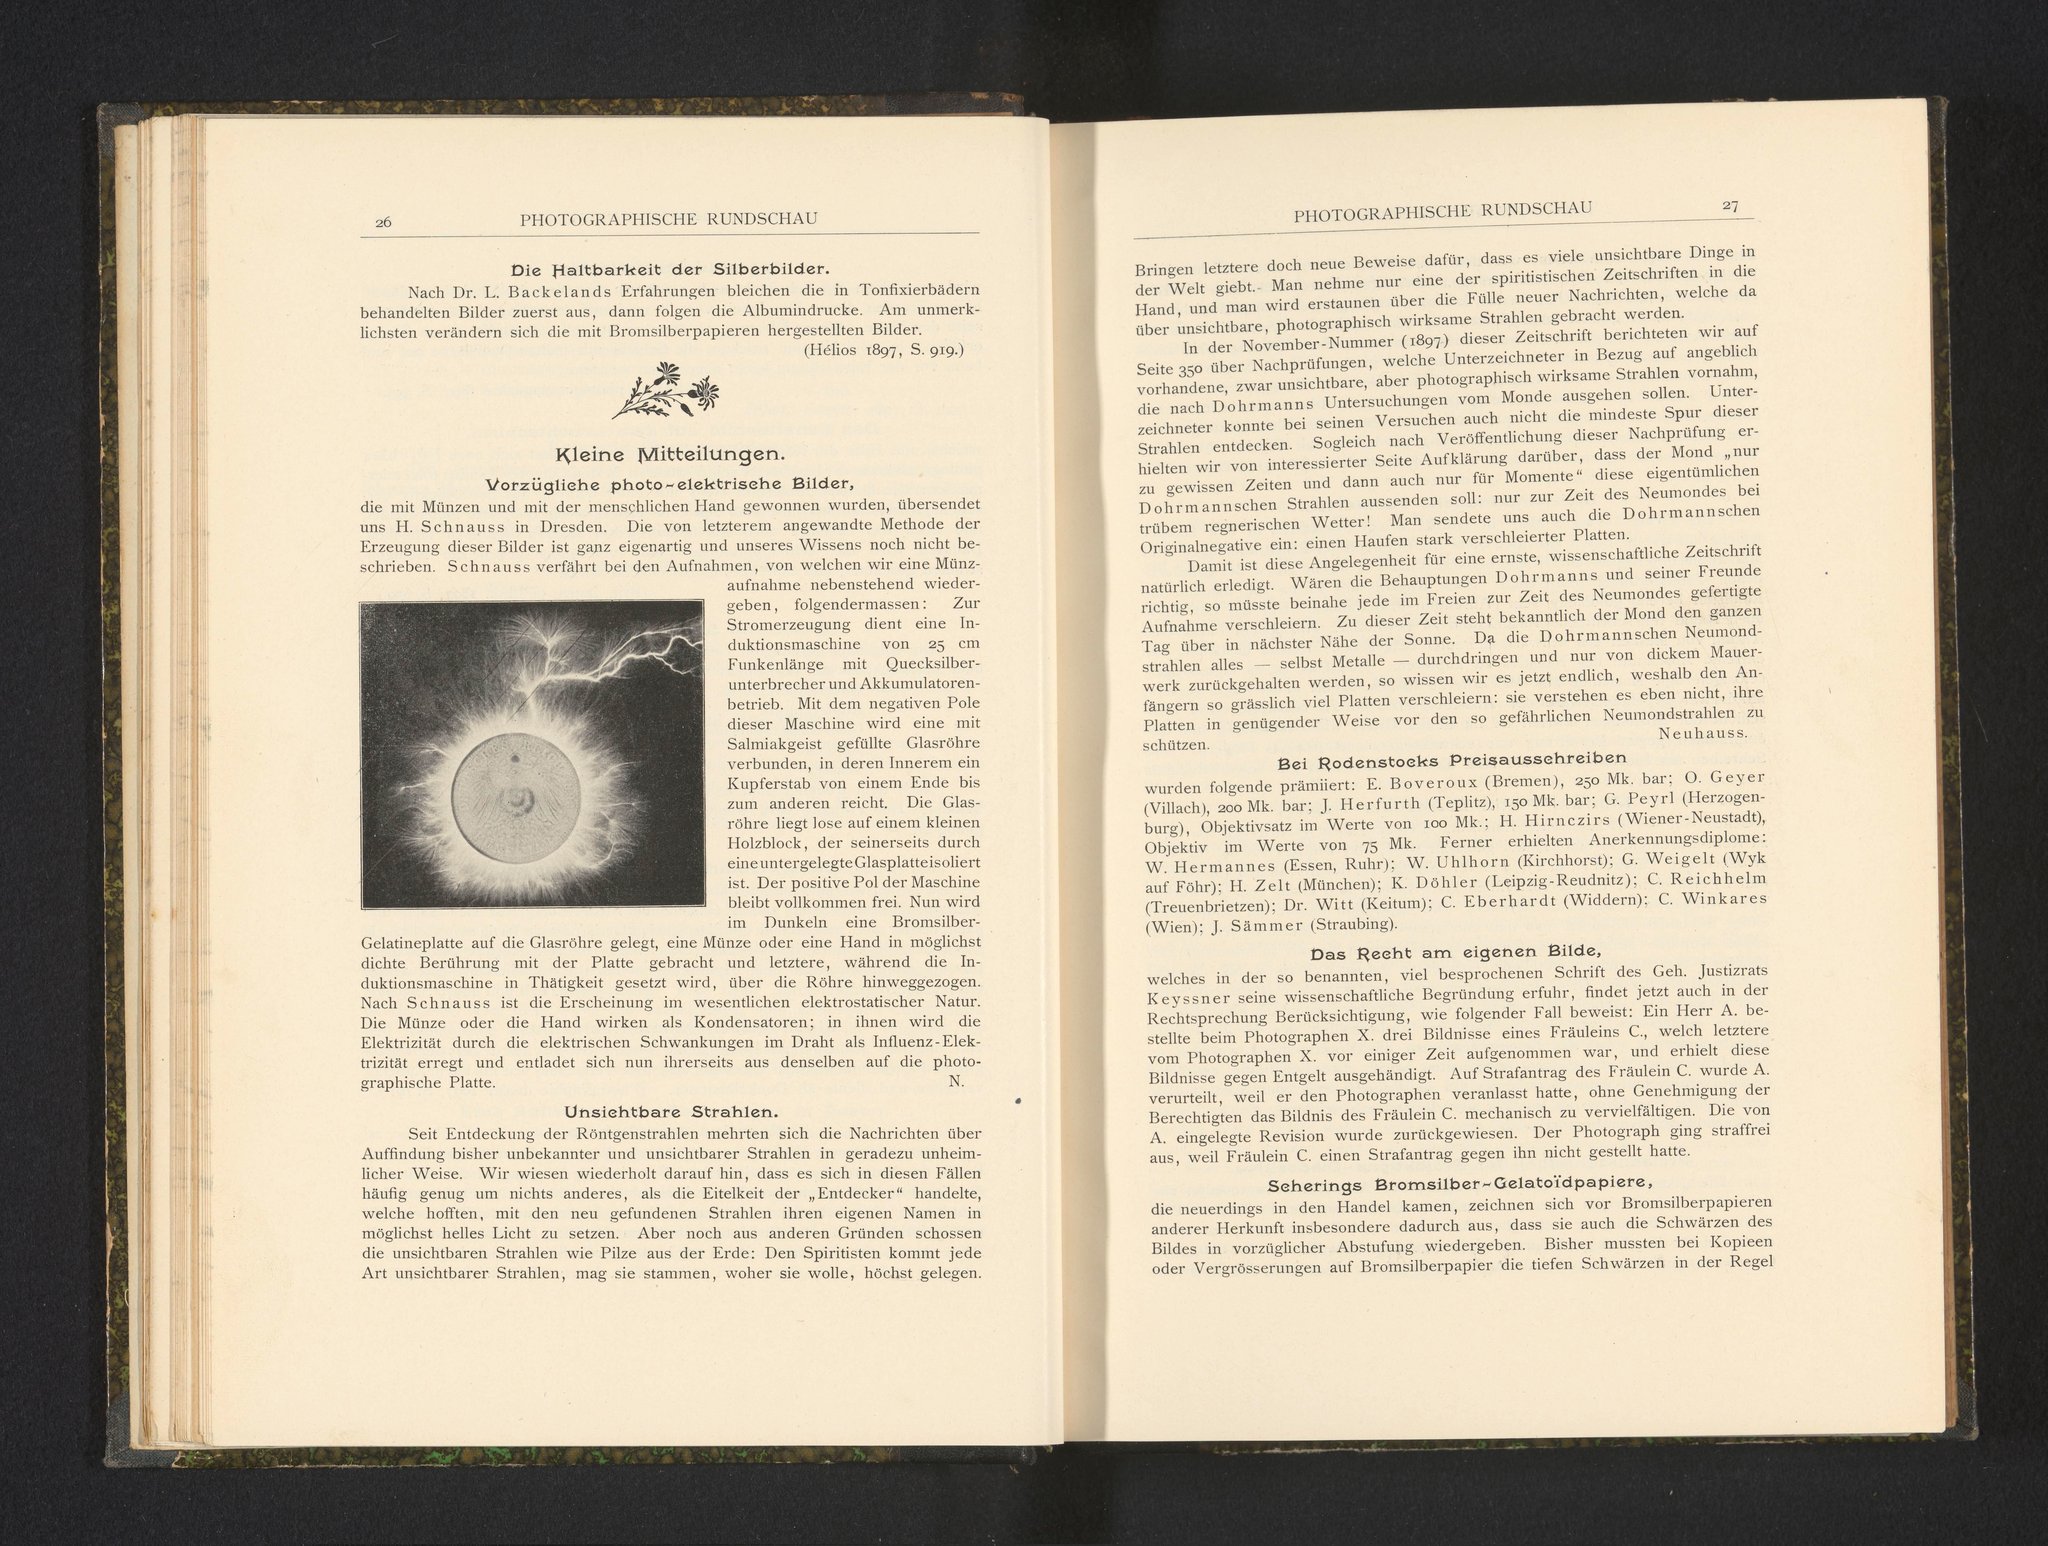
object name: page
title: Munt met een halo van elektrische stroom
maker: Anonymous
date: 1893-1898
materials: paper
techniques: autotype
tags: spark ~ electricity, coin